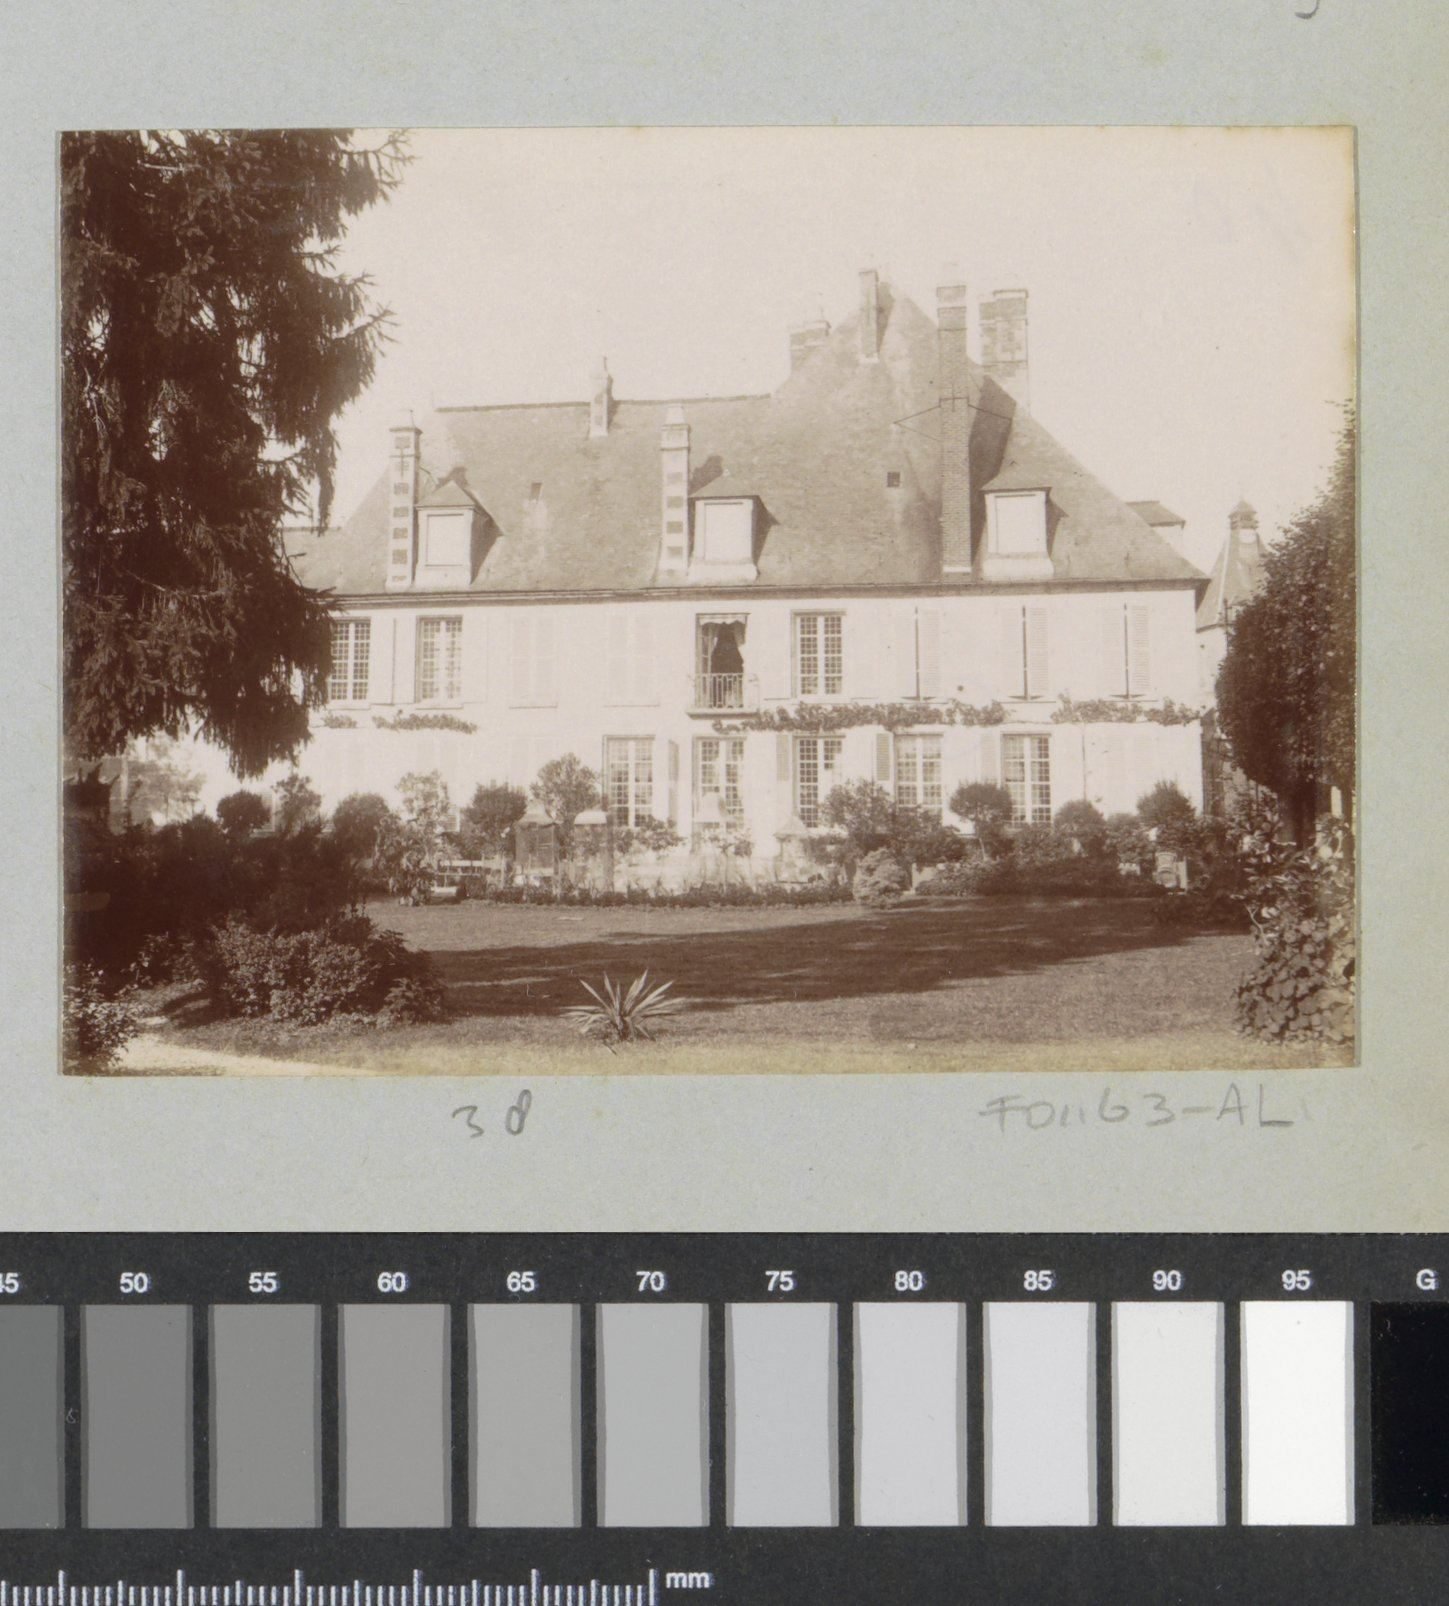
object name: photograph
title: Landhuis met tuin in Coucy-le-Château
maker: delizy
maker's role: manufacturer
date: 1809-1896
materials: paper, photographic support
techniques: gelatin silver print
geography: coucy-le-château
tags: garden, rural housing, e.g. country-house, villa, cottage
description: Onderdeel van Fotoalbum van een Franse amateurfotograaf met opnames van uitstapjes in Frankrijk, Spanje, België, Luxemburg en Nederland, de eerste automobielen en autoraces.